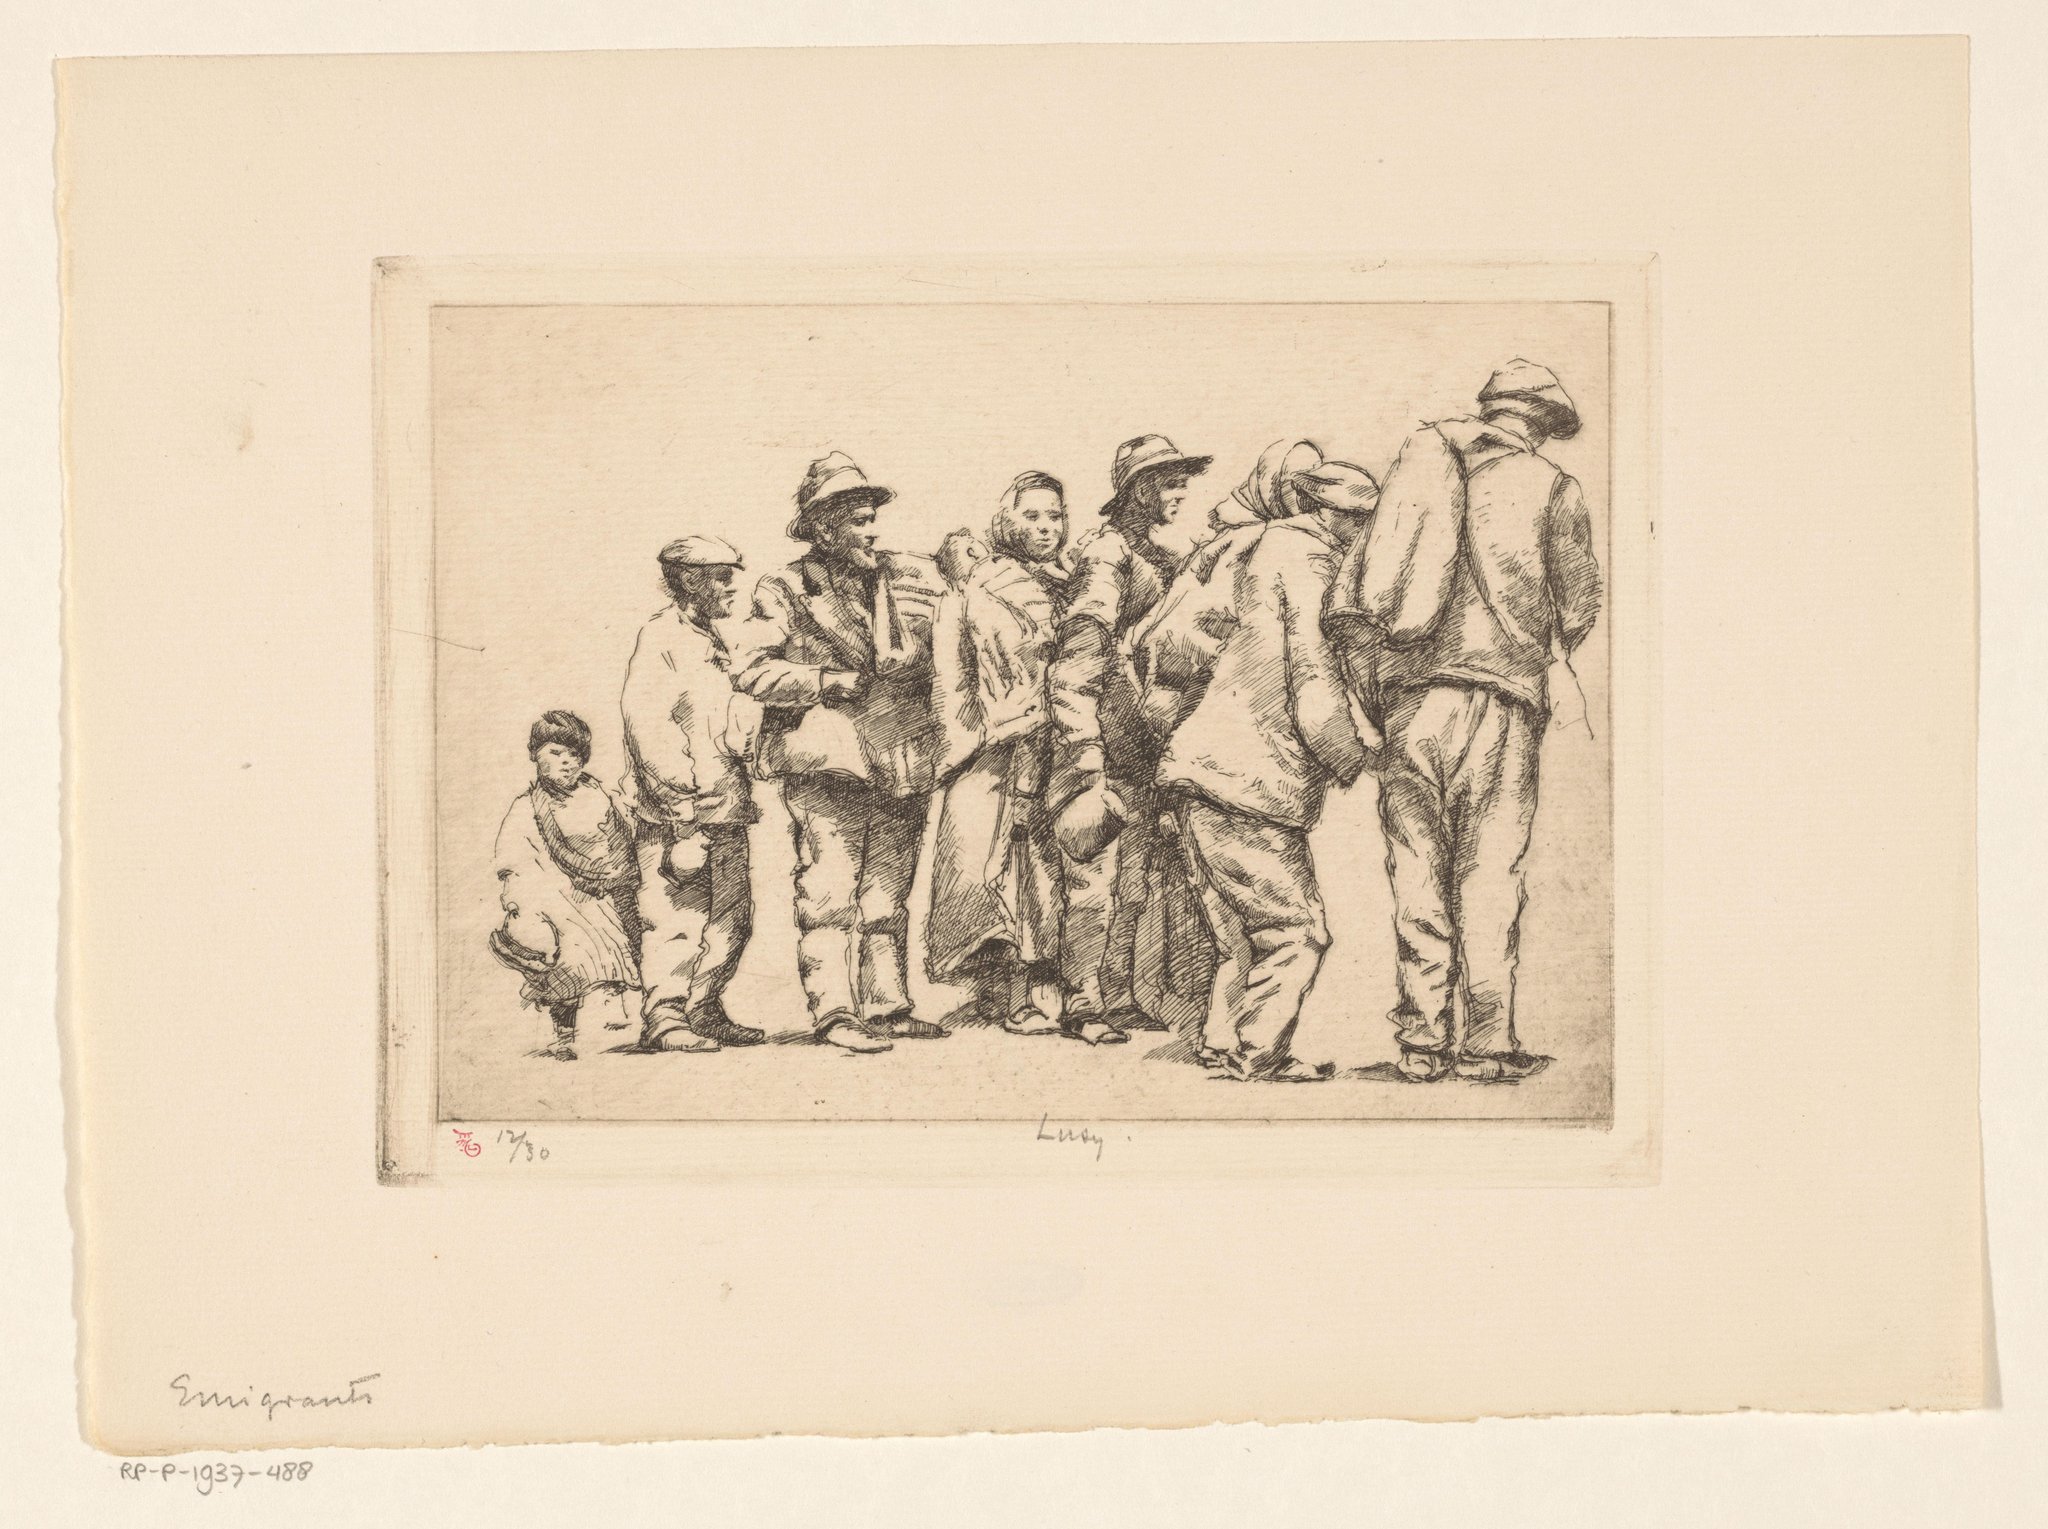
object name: print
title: Emigrants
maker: marino m. lusy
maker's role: print maker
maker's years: 1880-1954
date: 1890-1937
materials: paper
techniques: etching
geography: italy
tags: emigration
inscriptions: number: ‘12/30’, collector's mark: Lugt 2228, collector's mark: Lugt 2412a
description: Mannen, vrouwen en kinderen (emigranten) in een rij.